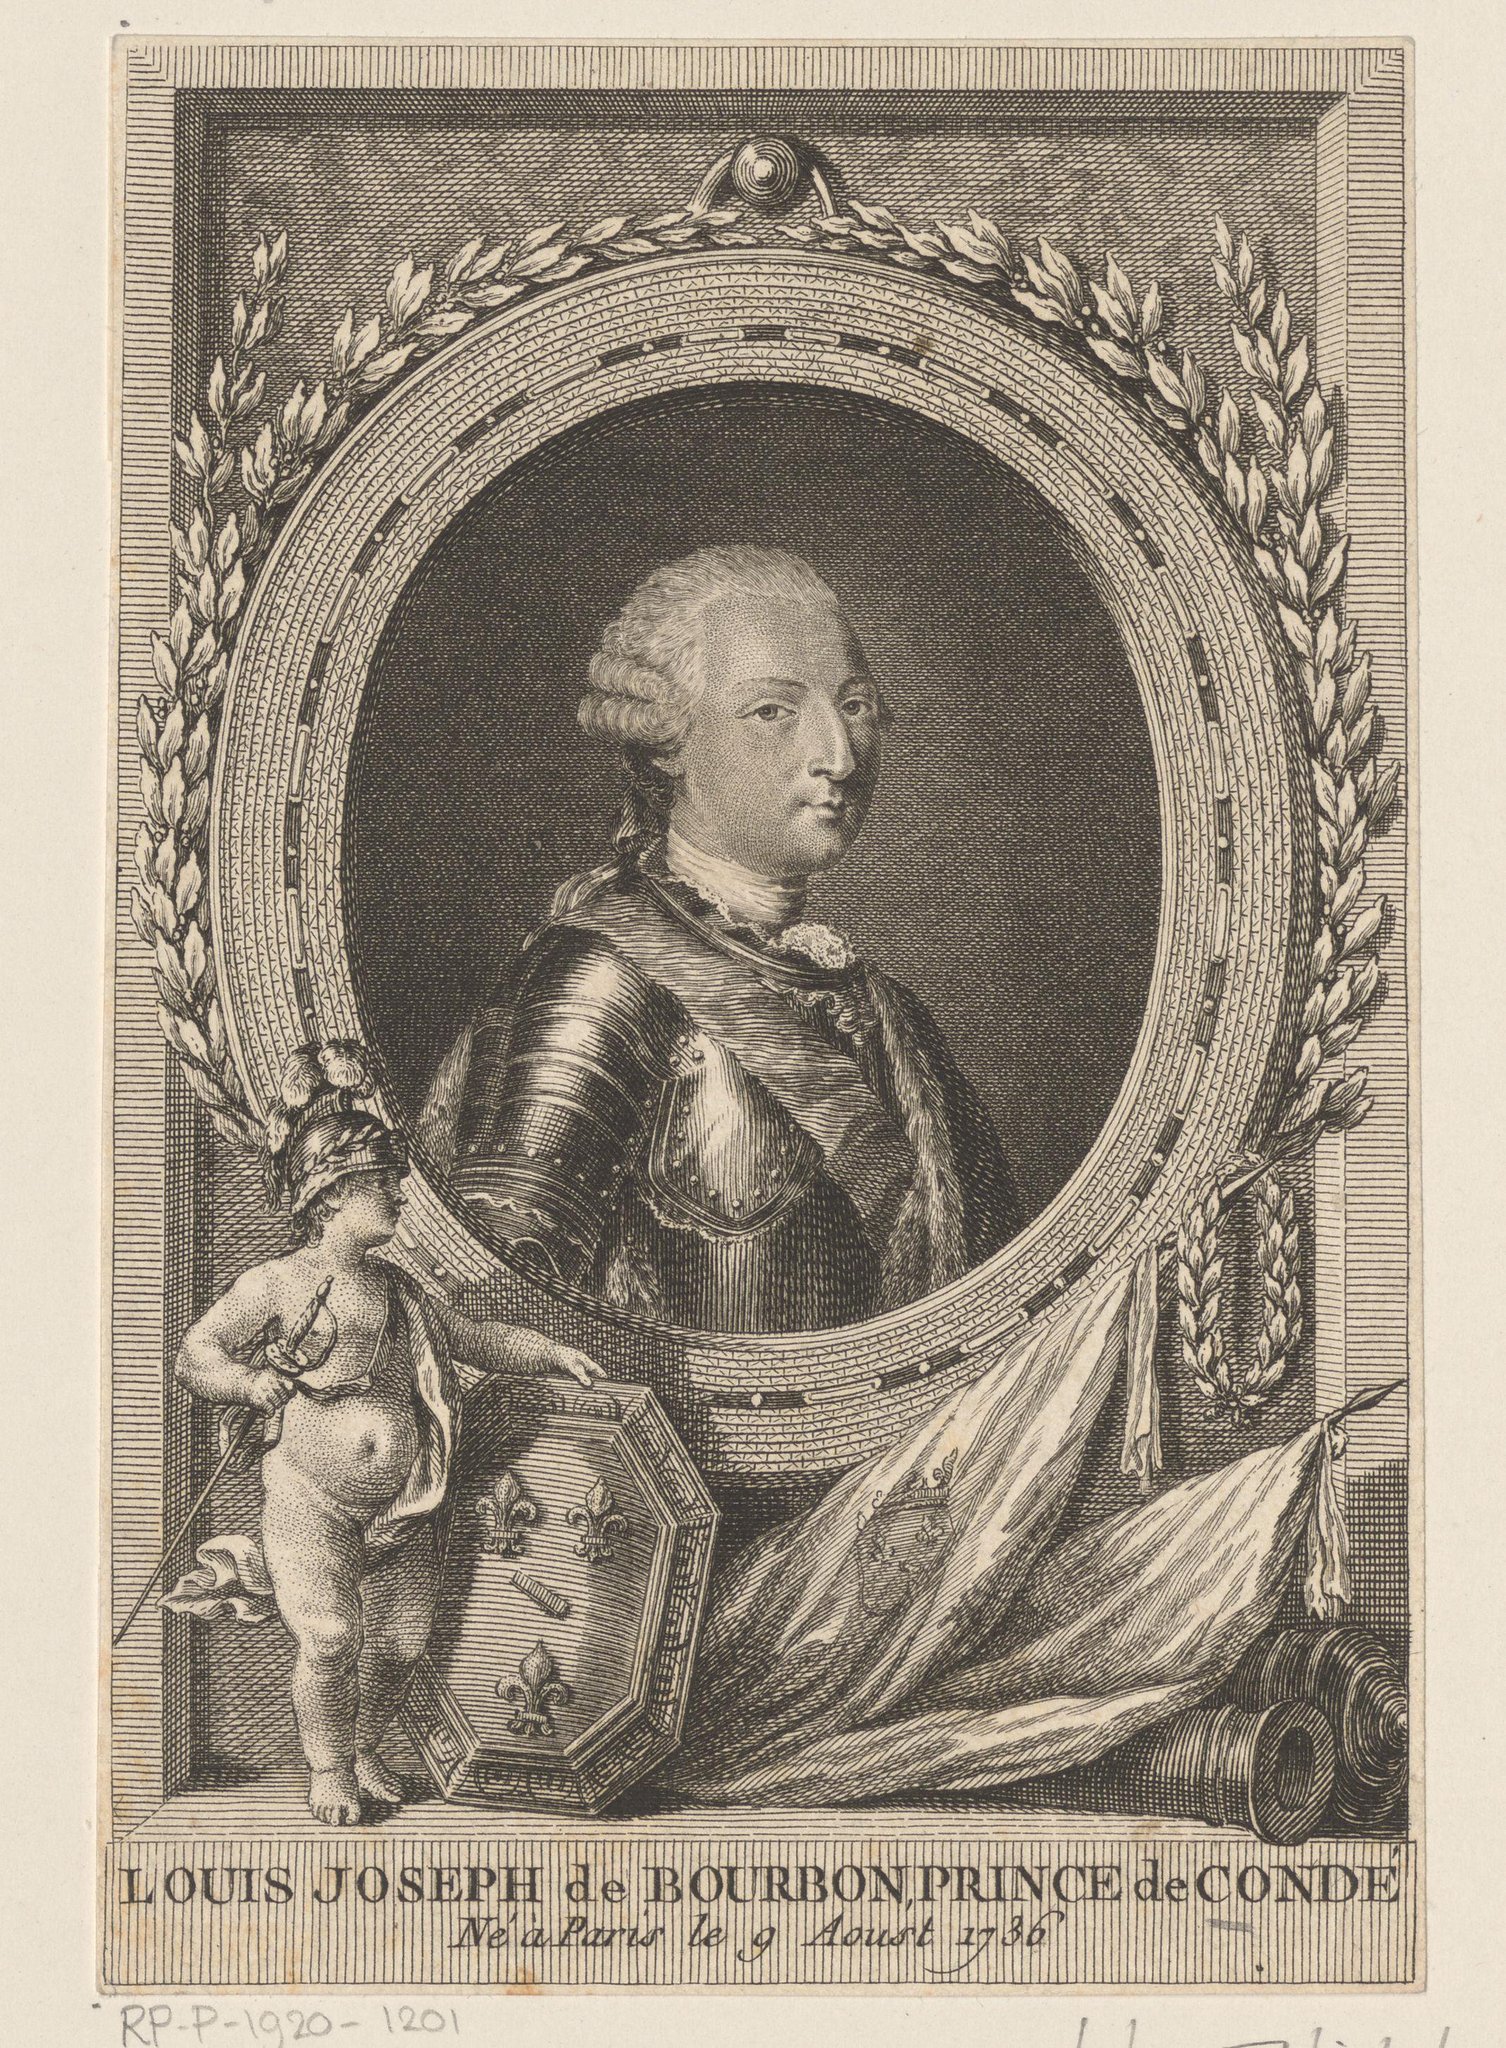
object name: print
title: Portret van Louis V Joseph van Bourbon-Condé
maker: Anonymous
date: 1756-1799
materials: paper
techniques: engraving, etching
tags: louis v joseph van bourbon-condé, historical persons, cupids: 'amores', 'amoretti', 'putti'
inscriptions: collector's mark: Lugt 2228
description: Onder het portret een putto met helm en schild.